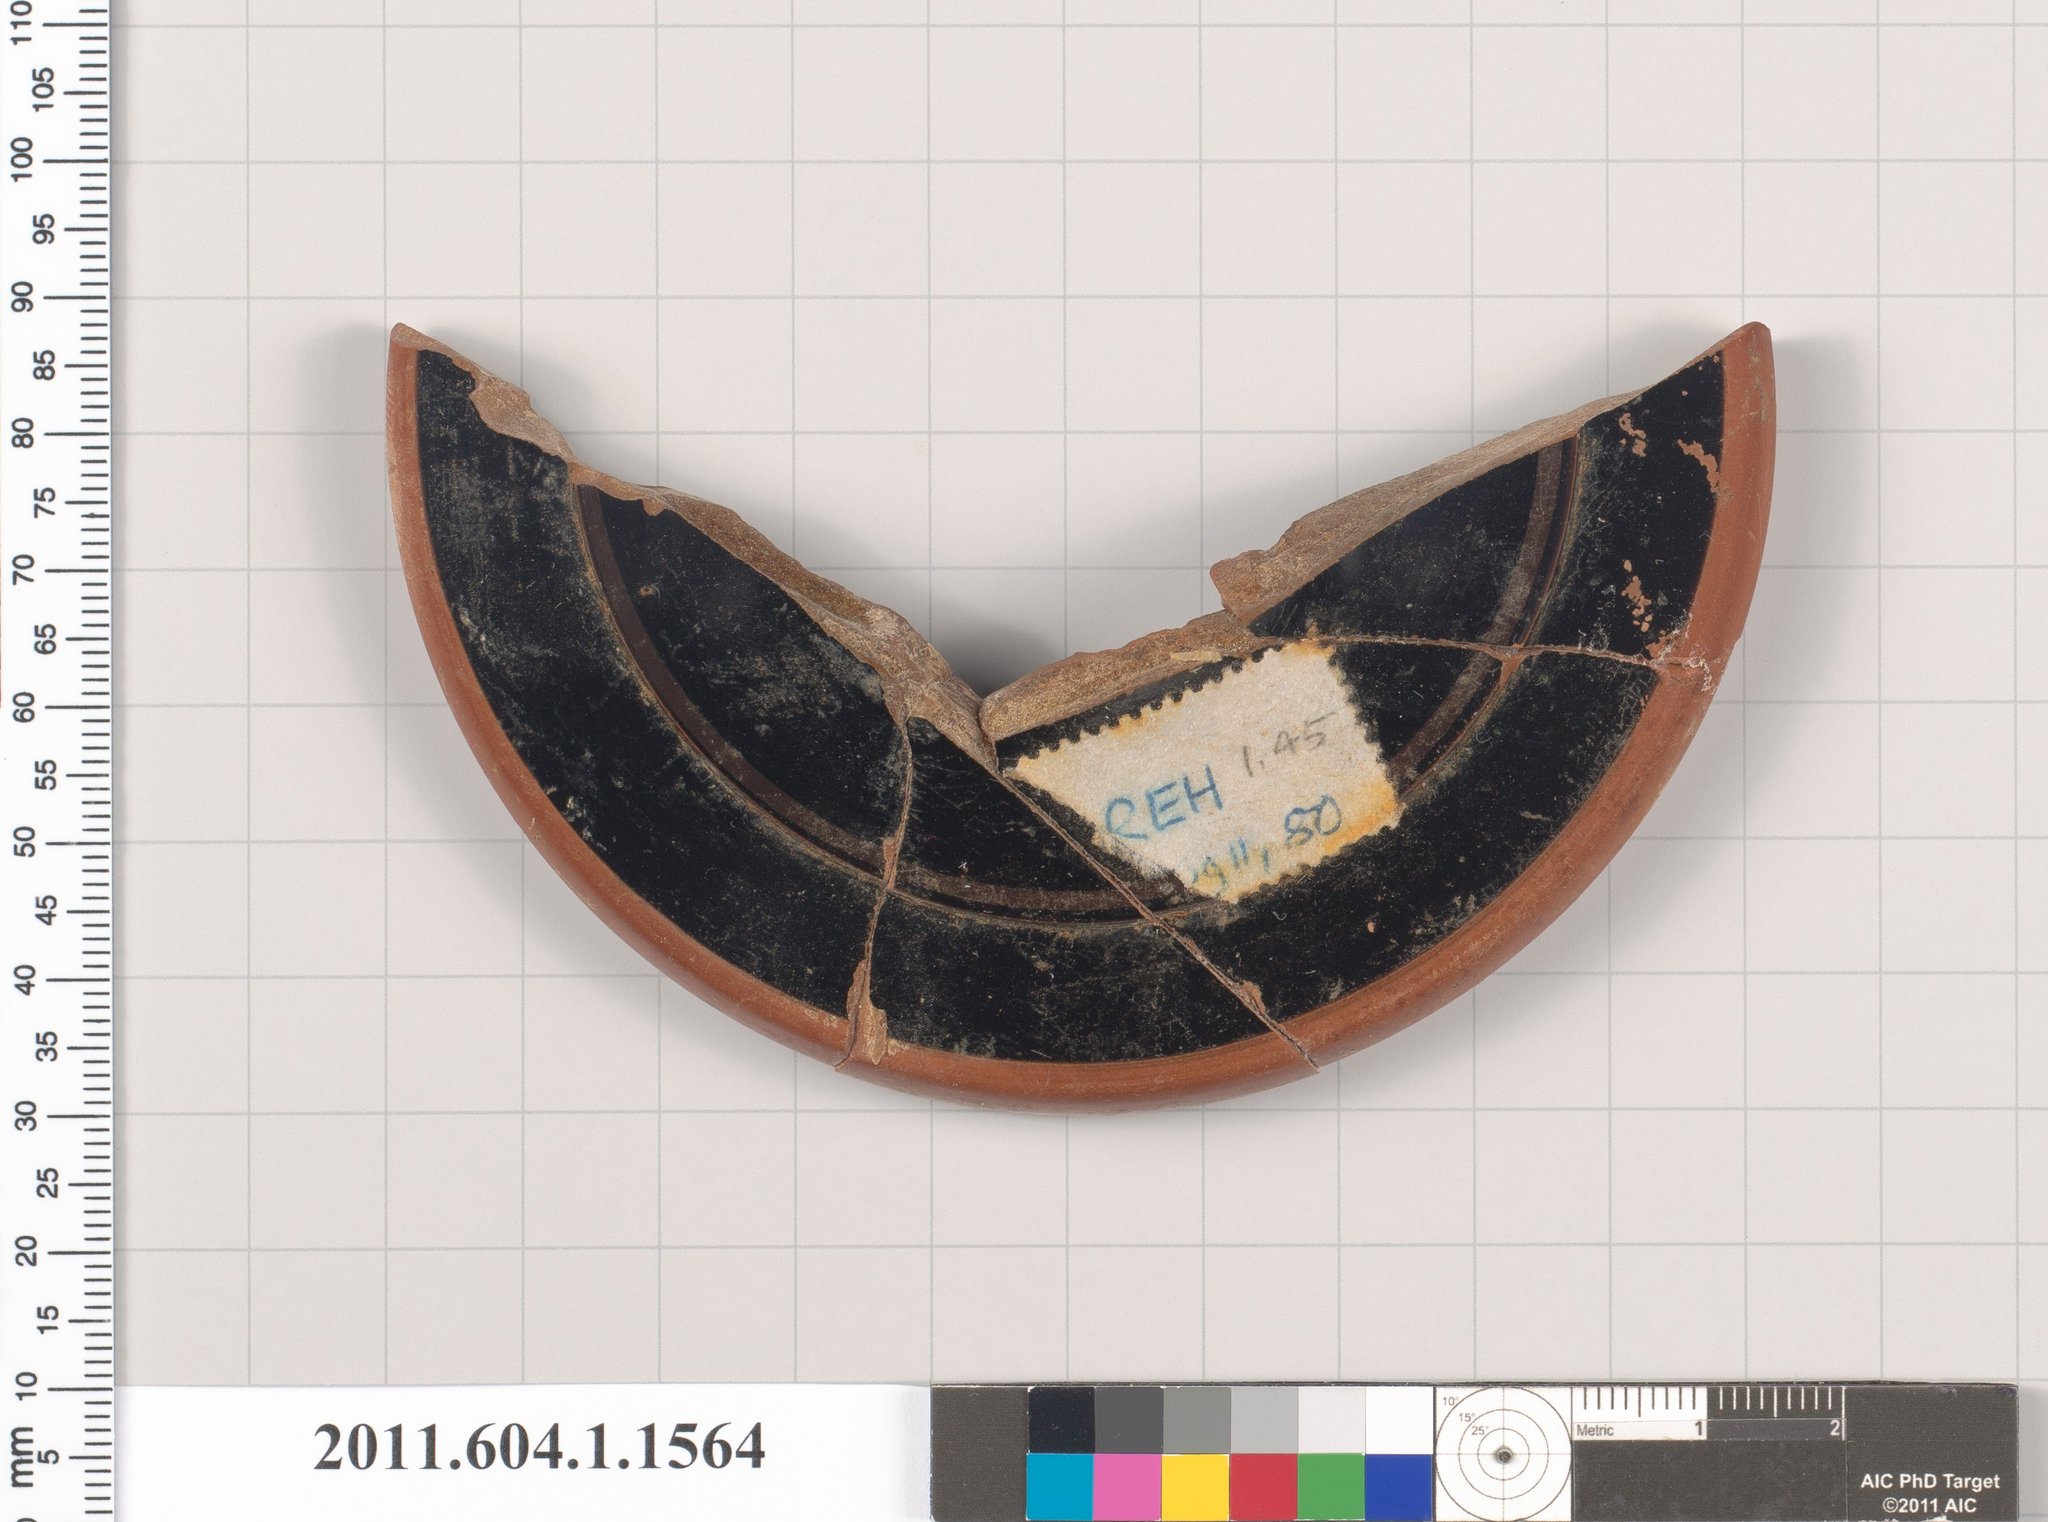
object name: kylix fragment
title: Terracotta fragment of a kylix (drinking cup)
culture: greek, attic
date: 500-401 BCE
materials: terracotta